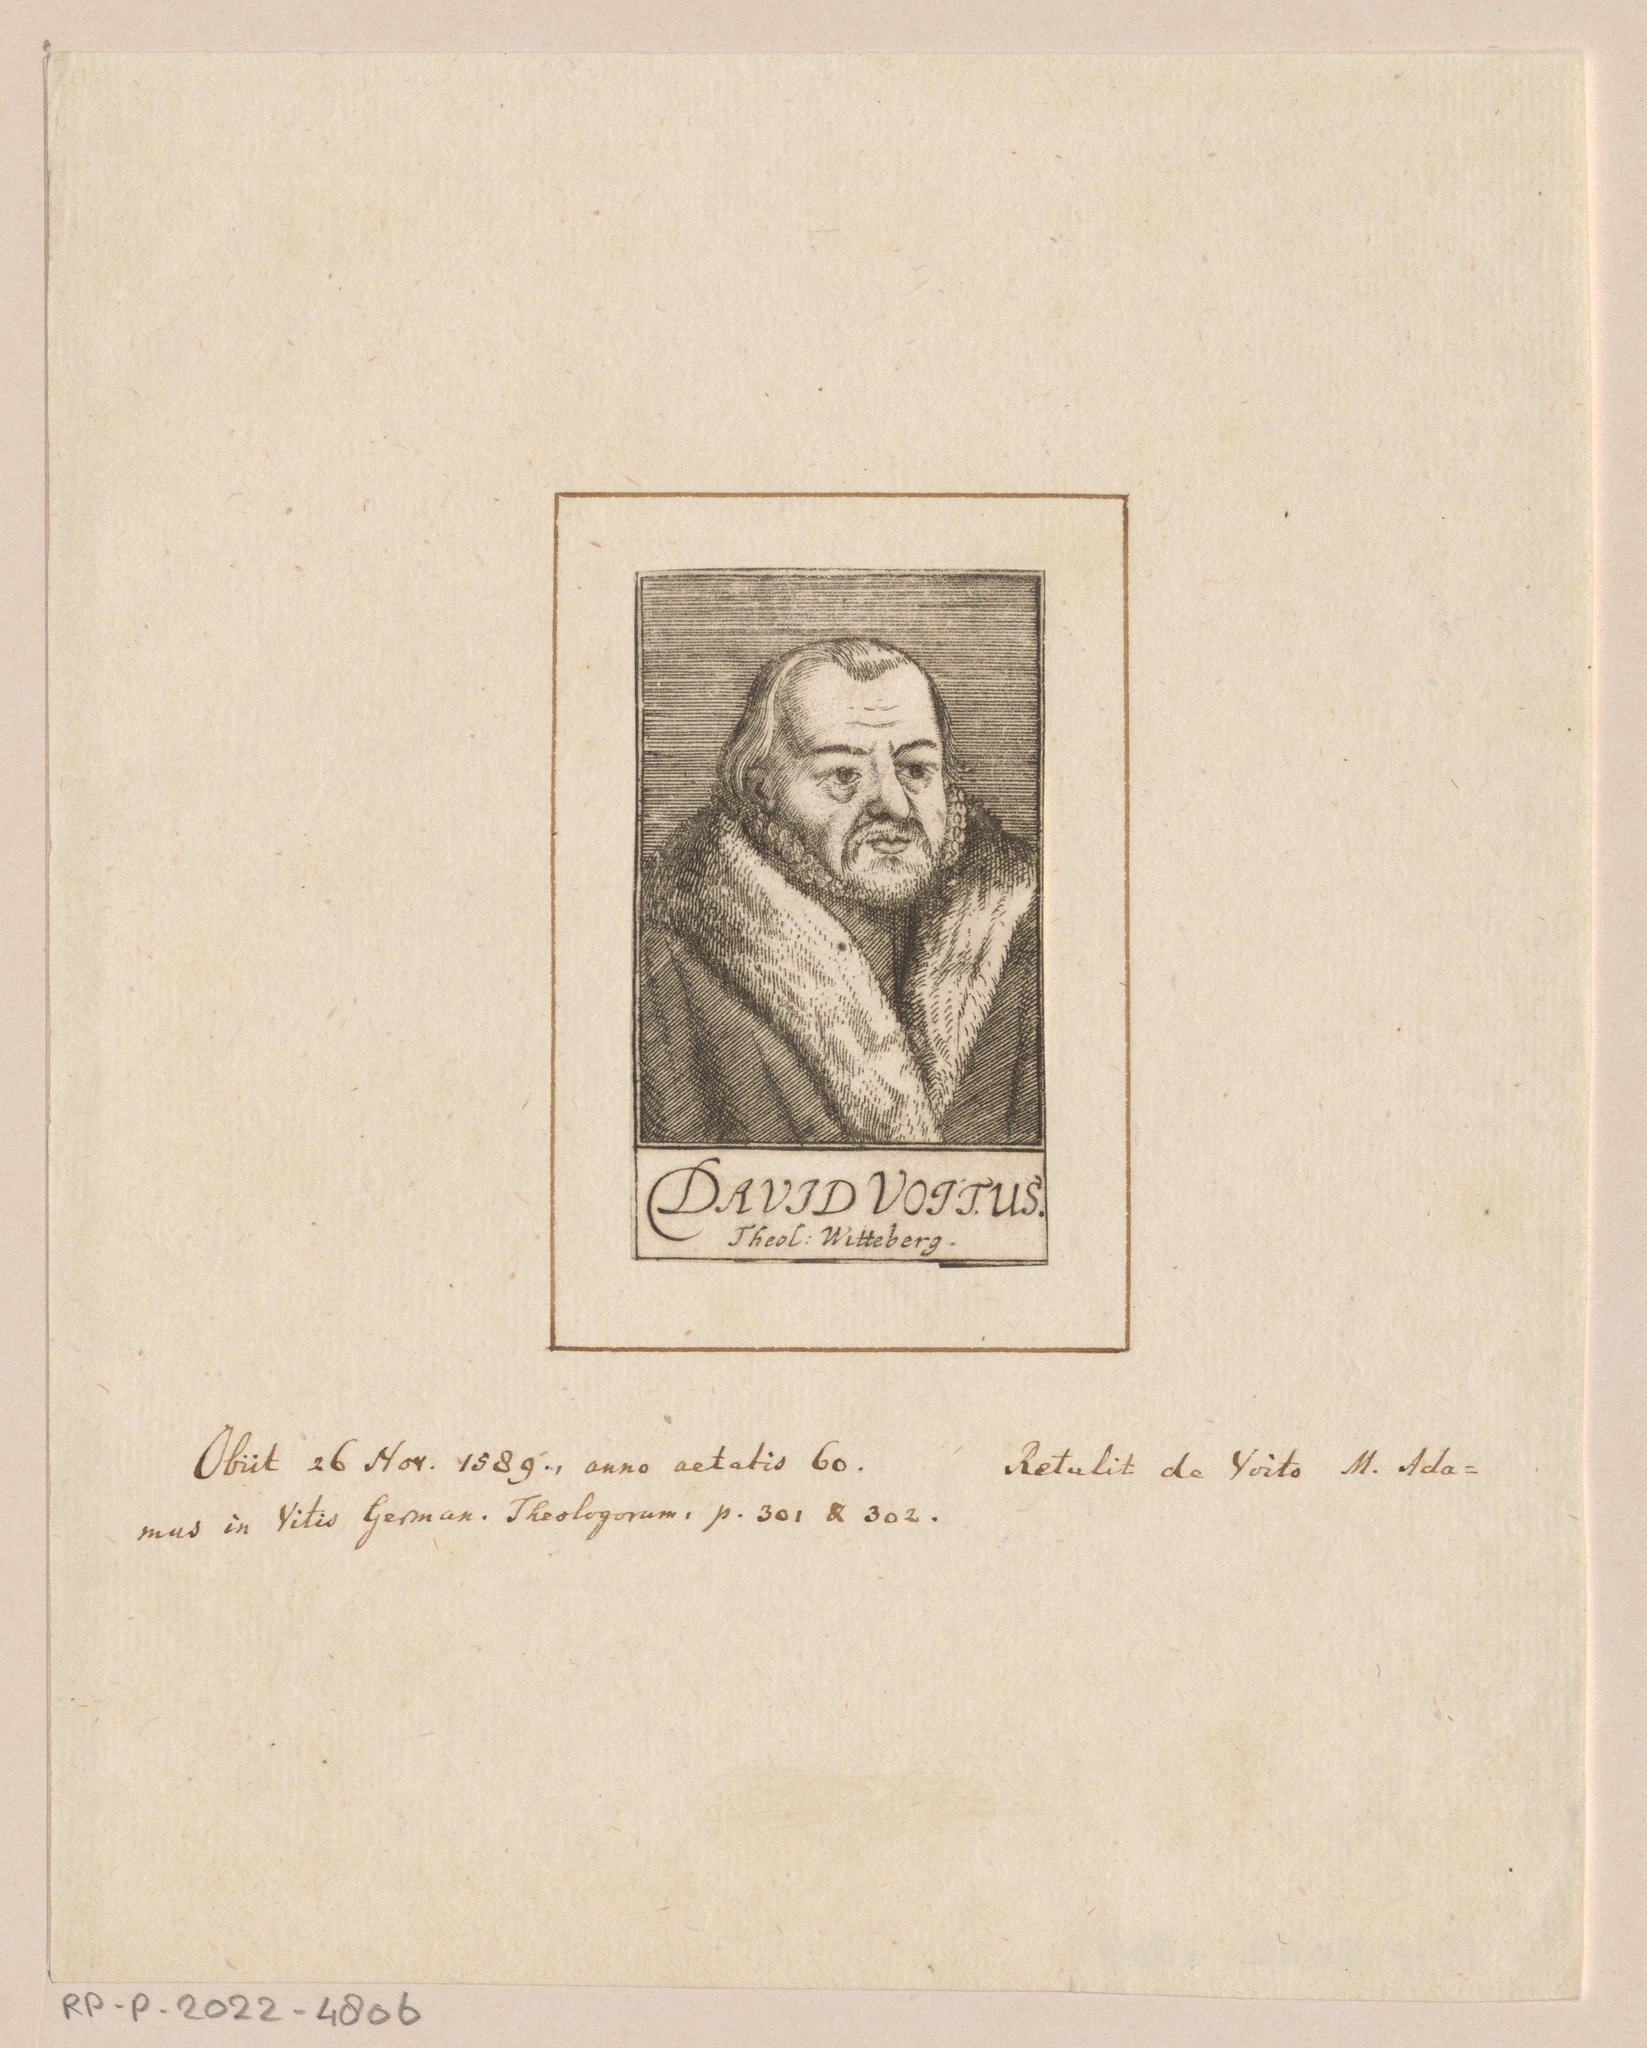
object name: print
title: Portret van David Voit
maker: Anonymous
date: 1688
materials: paper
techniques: engraving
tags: theologian, historical persons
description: Prent waarschijnlijk uit: Freher, Paul. Theatrum Virorum Eruditione Clarorum Tomus Posterior. Neurenberg: Johann Hofmann, 1688.